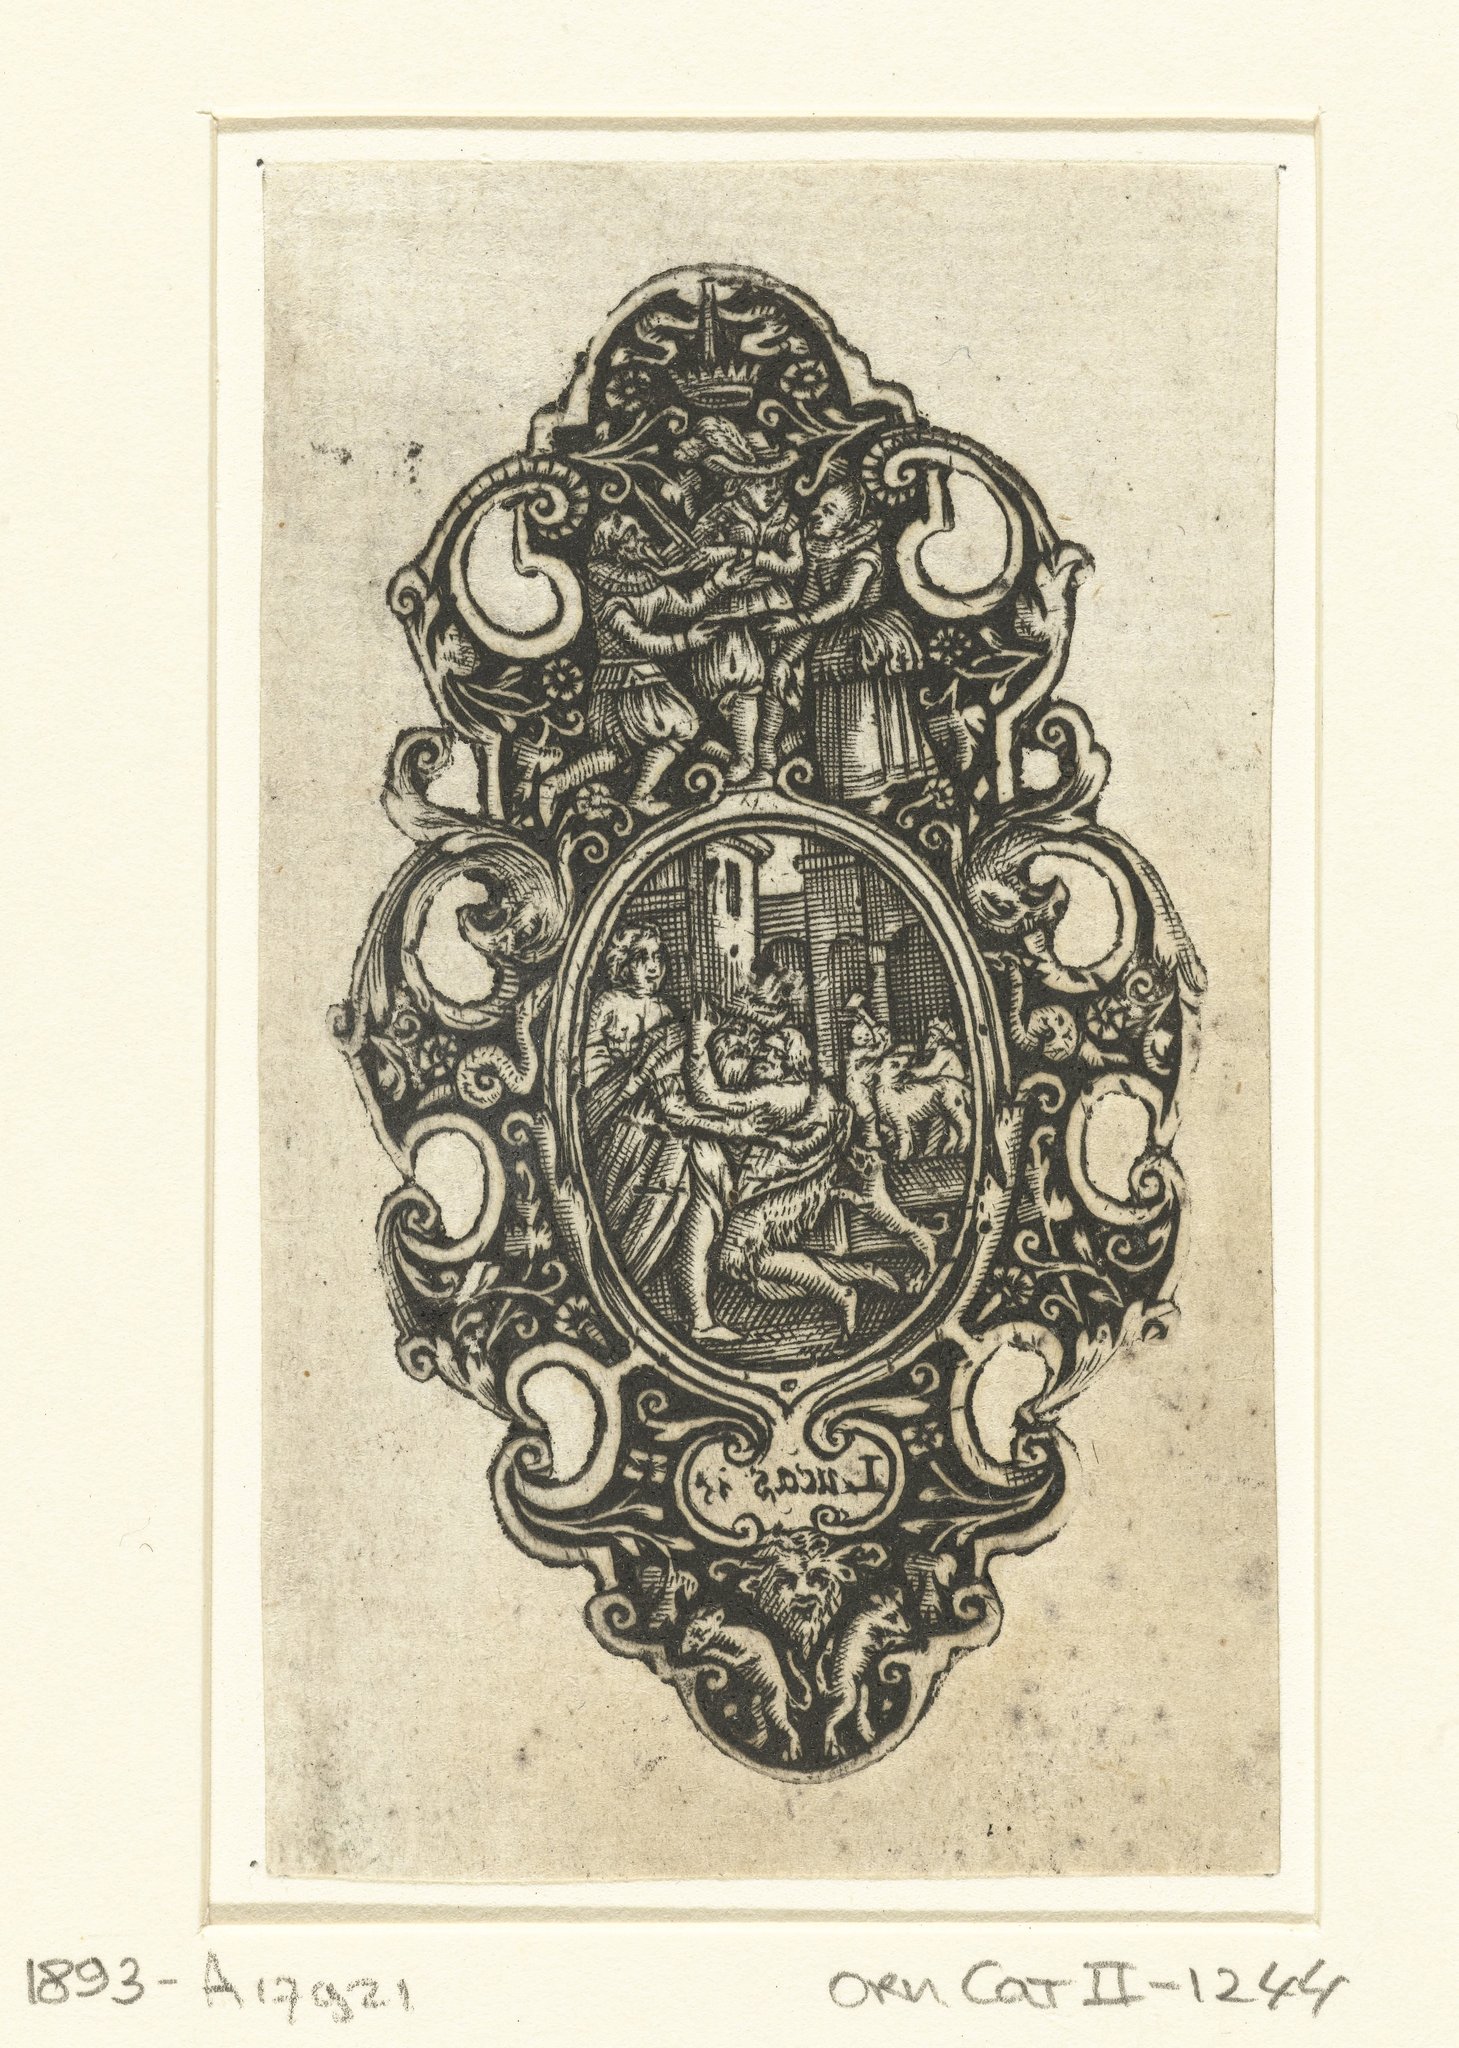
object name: print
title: Plaquette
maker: Anonymous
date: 1600-1620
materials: paper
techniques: engraving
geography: netherlands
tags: the parable of the prodigal son (luke 15:11-32)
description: In het midden een ovaal medaillon met daarin een voorstelling van de terugkomst van de verloren zoon. Daarboven knielt een man voor een vrouw, tussen hen in staat een vioolspelende man. Afdruk van een gegraveerde plaquette.